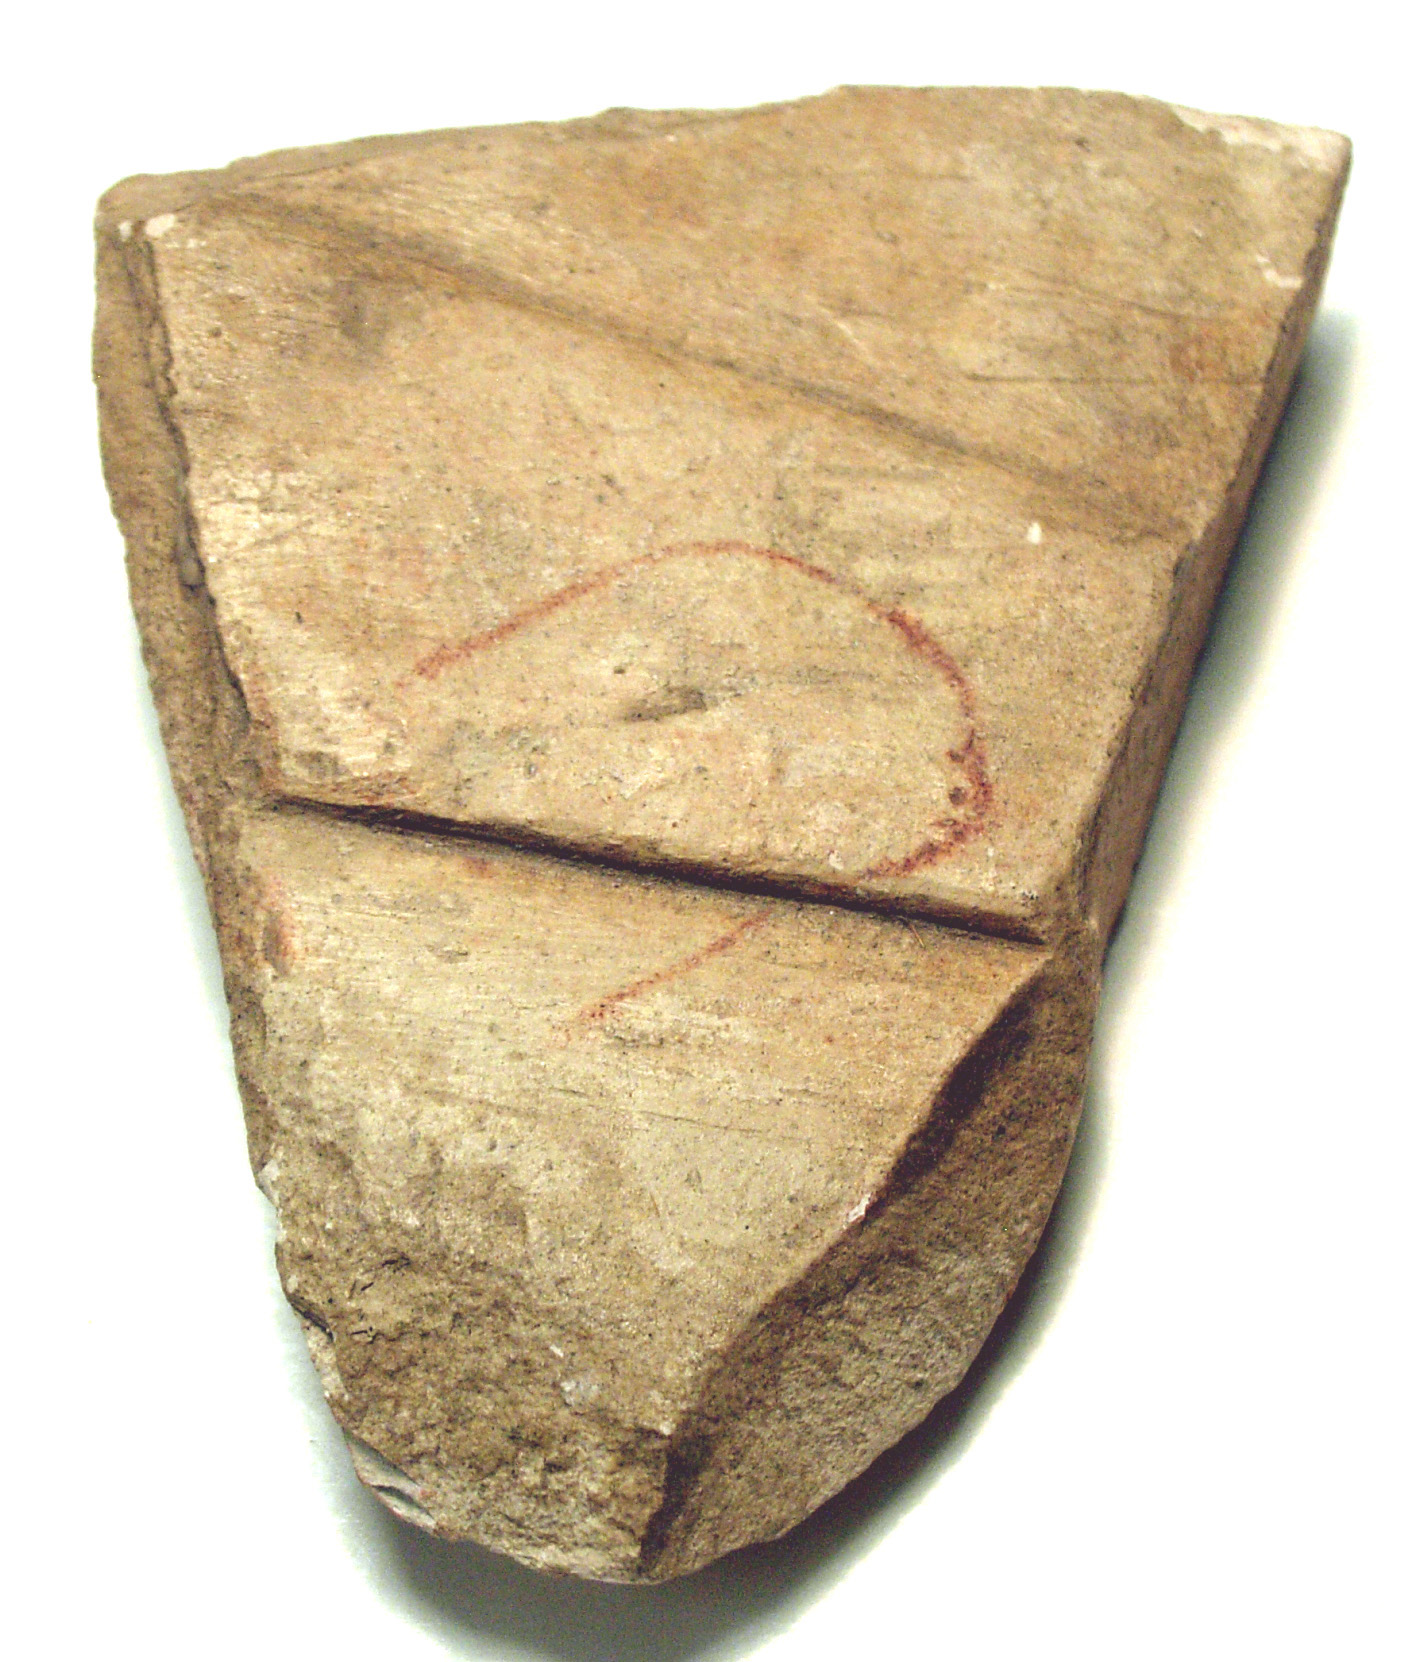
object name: relief, tomb of nespekashuty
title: Raised relief fragment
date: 664-610 BCE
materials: limestone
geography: egypt